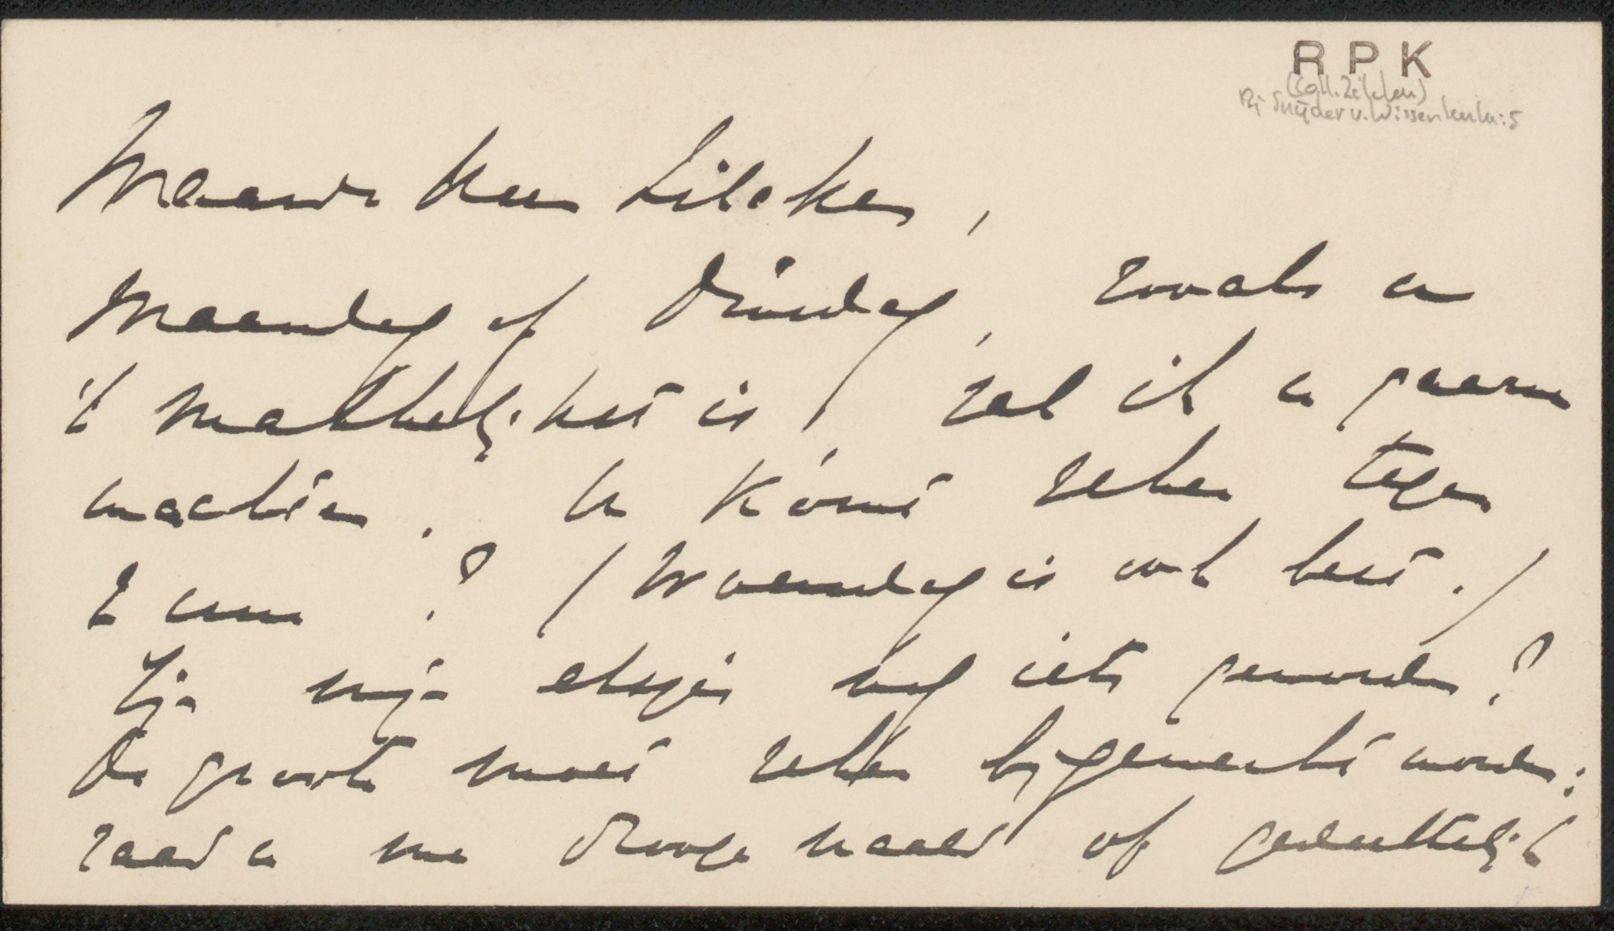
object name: letter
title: Brief aan Philip Zilcken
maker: marie constance antoinette clant van der mijll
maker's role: draughtsman, painter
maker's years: 1864-1945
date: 1874-1930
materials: cardboard, ink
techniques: pen, writing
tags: the hague, painter, draughtsman, philip zilcken, the graphic arts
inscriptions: collector's mark: ‘RPK’